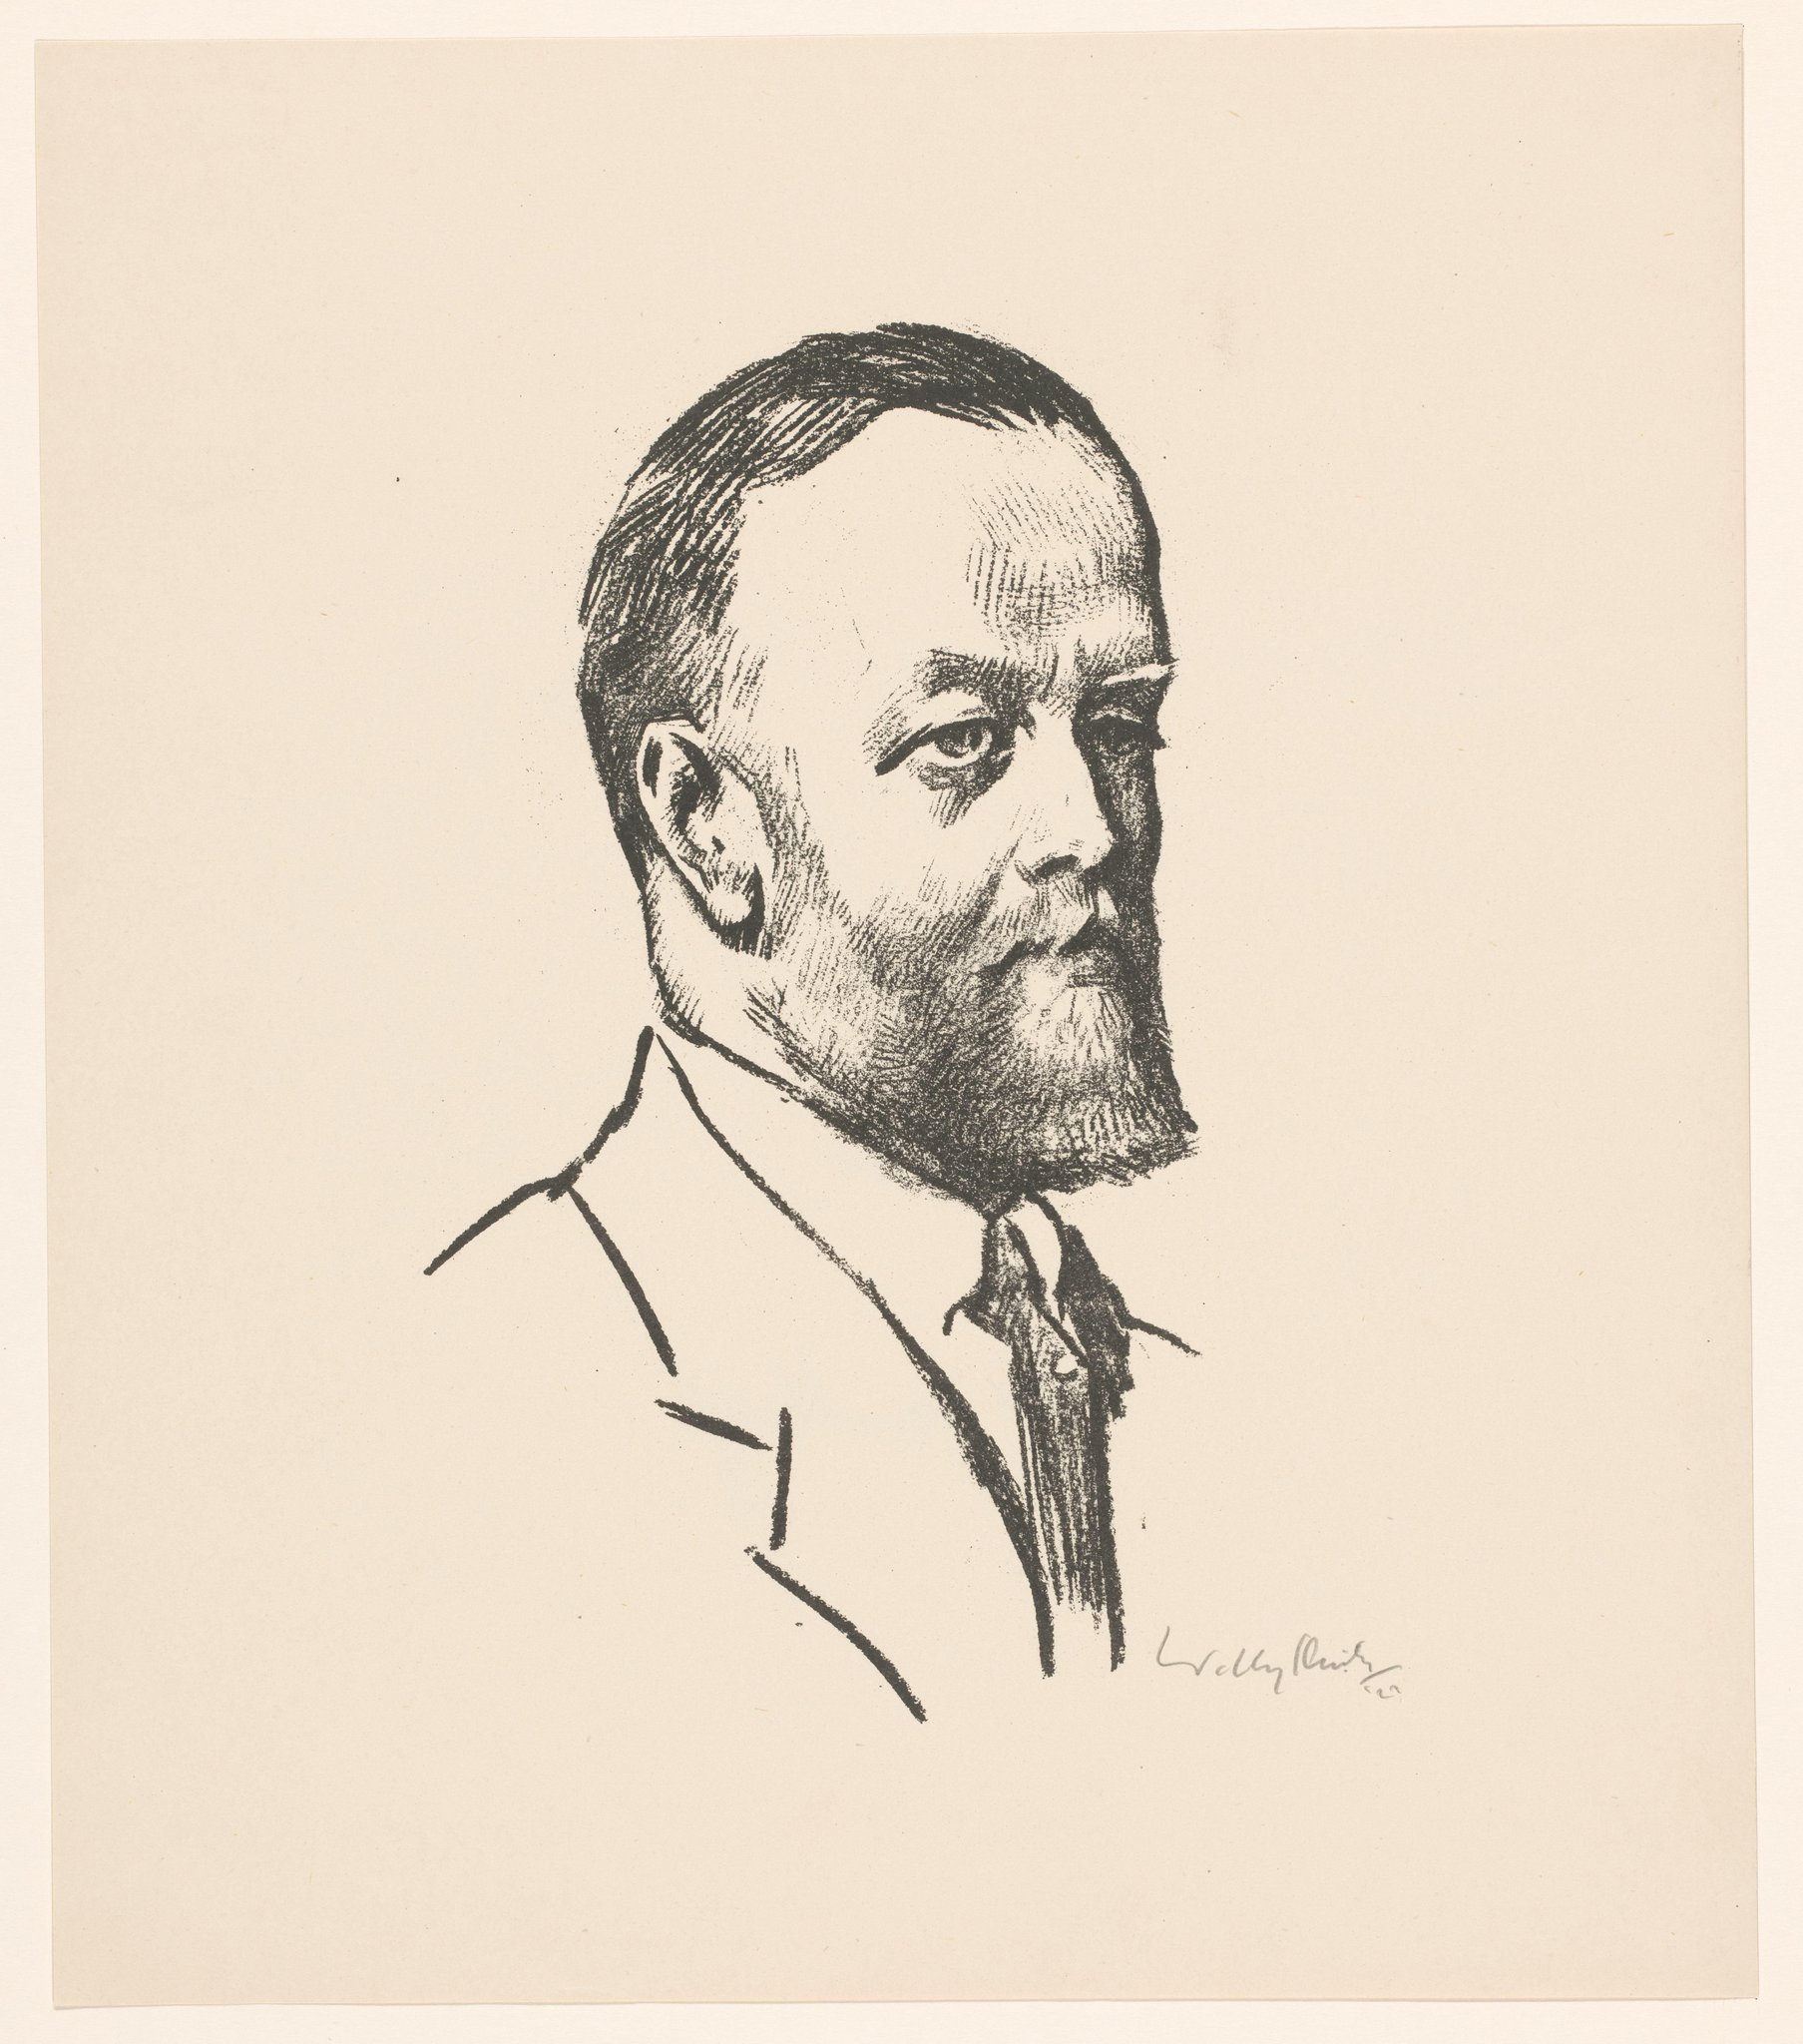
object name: print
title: Portret van Jan Kalf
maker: willy sluiter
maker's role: draughtsman, painter, print maker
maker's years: 1873-1949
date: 1922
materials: paper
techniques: lithograph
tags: amsterdam, jan kalf, historical persons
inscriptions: collector's mark: Lugt 2228